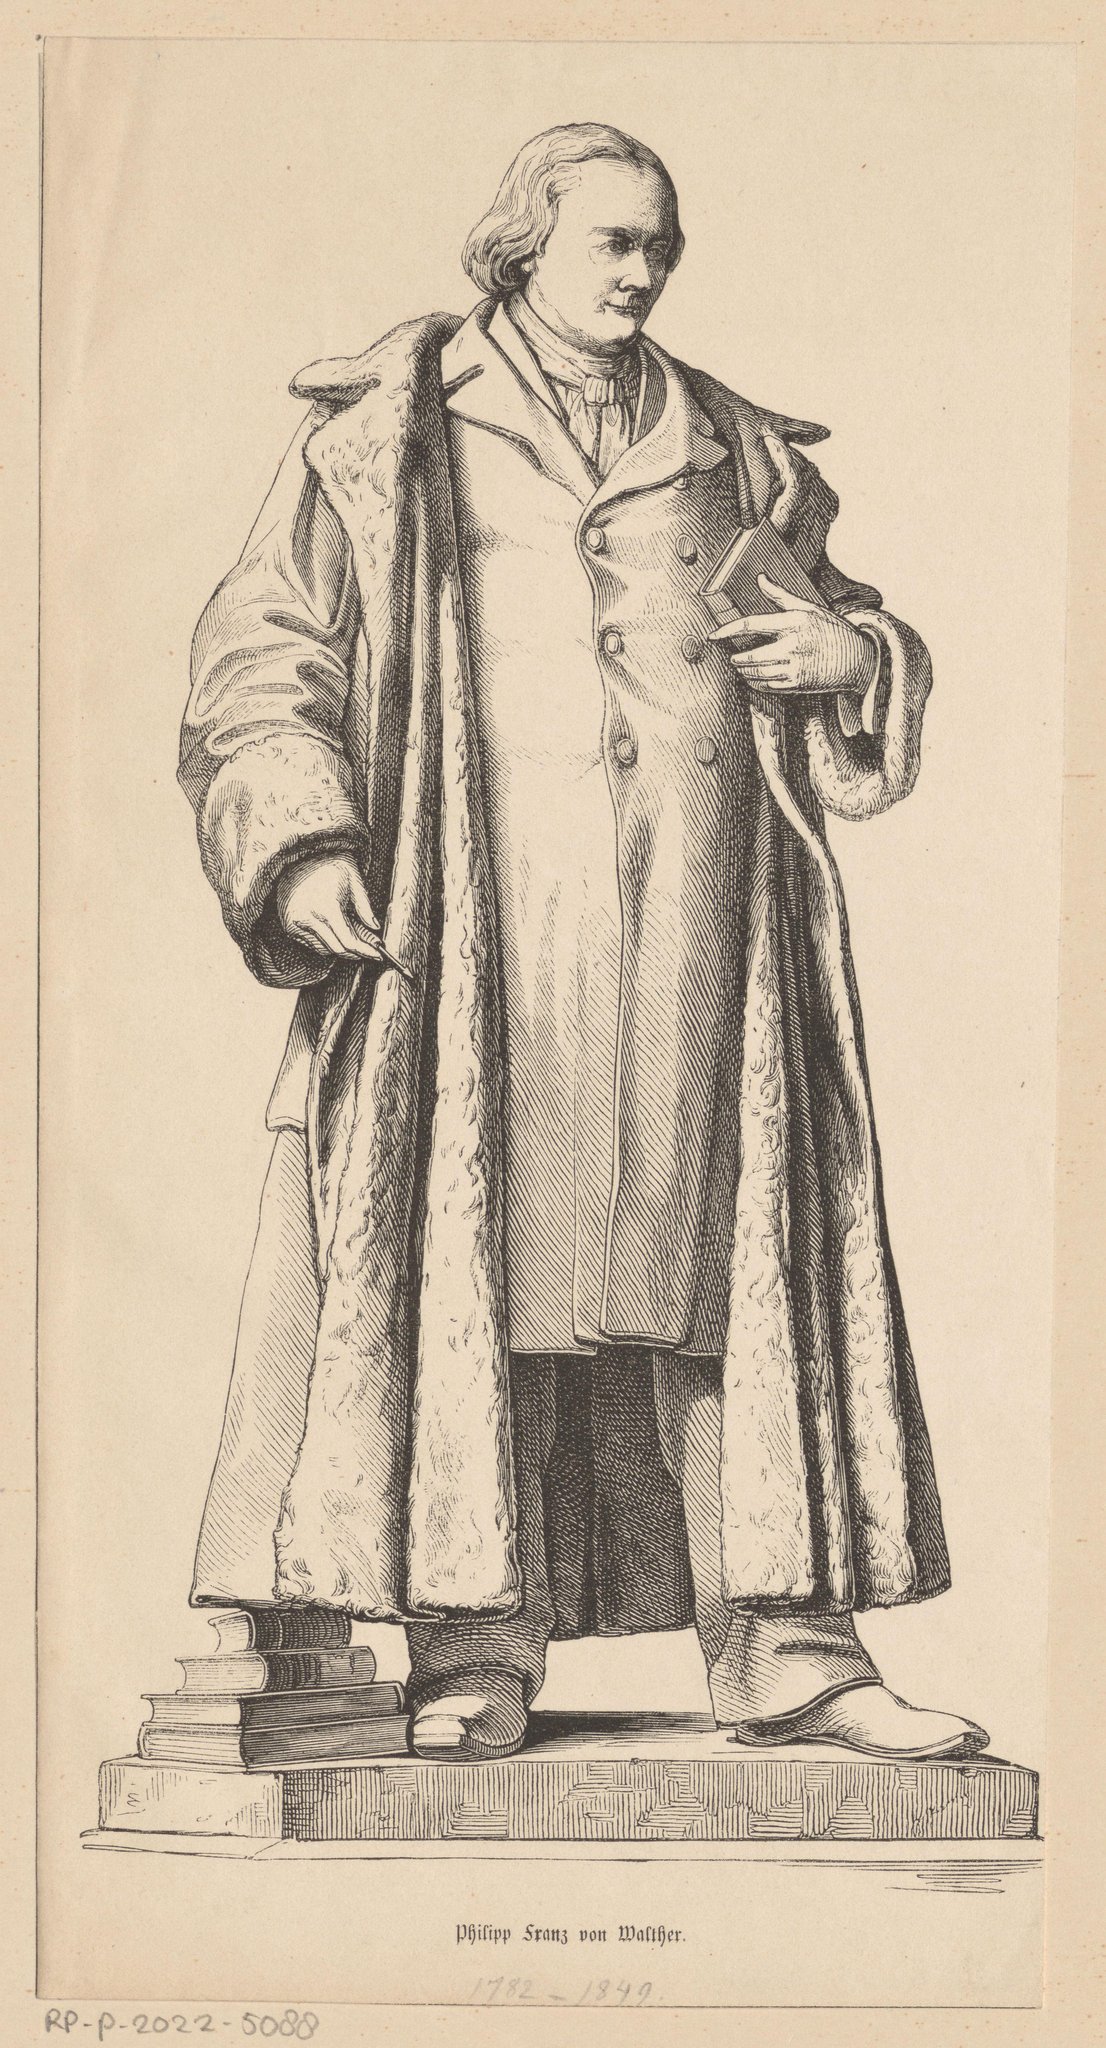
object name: print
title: Grafmonument van Philipp Franz von Walther op de Alter Südfriedhof in München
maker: Anonymous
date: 1850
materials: paper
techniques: letterpress printing, engraving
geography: germany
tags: historical persons, physician, doctor, book, monument, statue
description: Prent met ander onderschrift gebruikt in: Illustrirte Zeitung, nr. 359, 18 mei 1850.